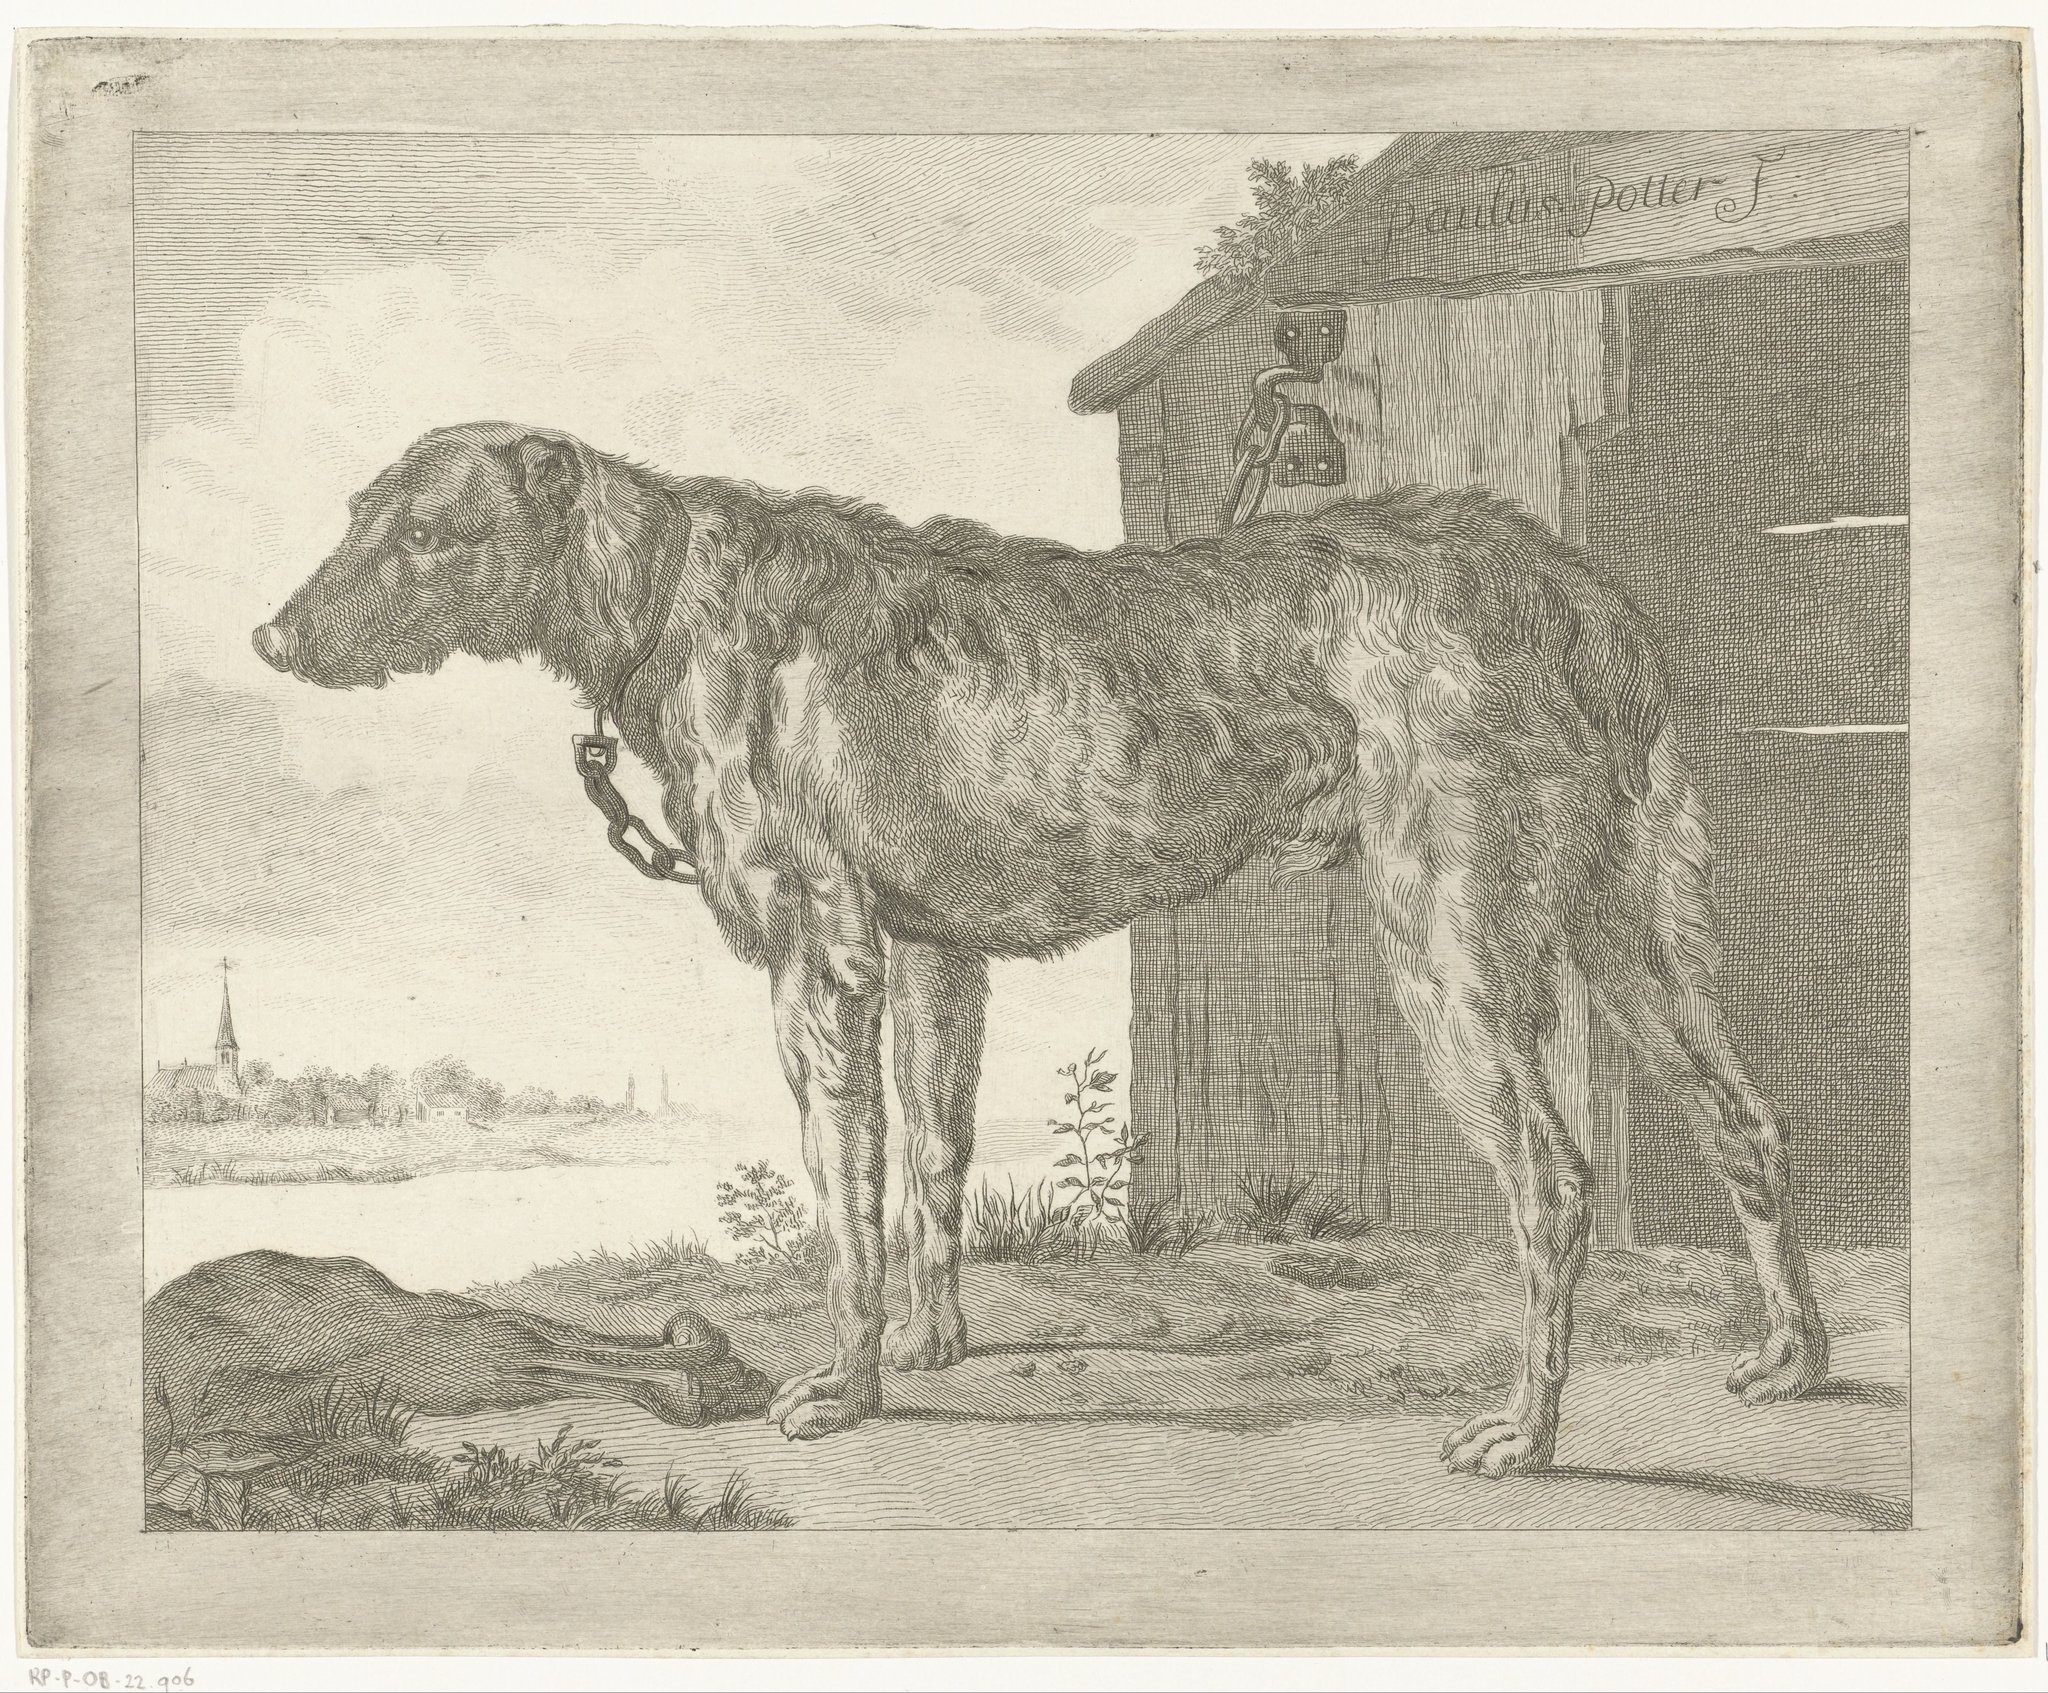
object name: print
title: Hond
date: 1768-1796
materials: paper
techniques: etching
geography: leiden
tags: dog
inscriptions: collector's mark: Lugt 240